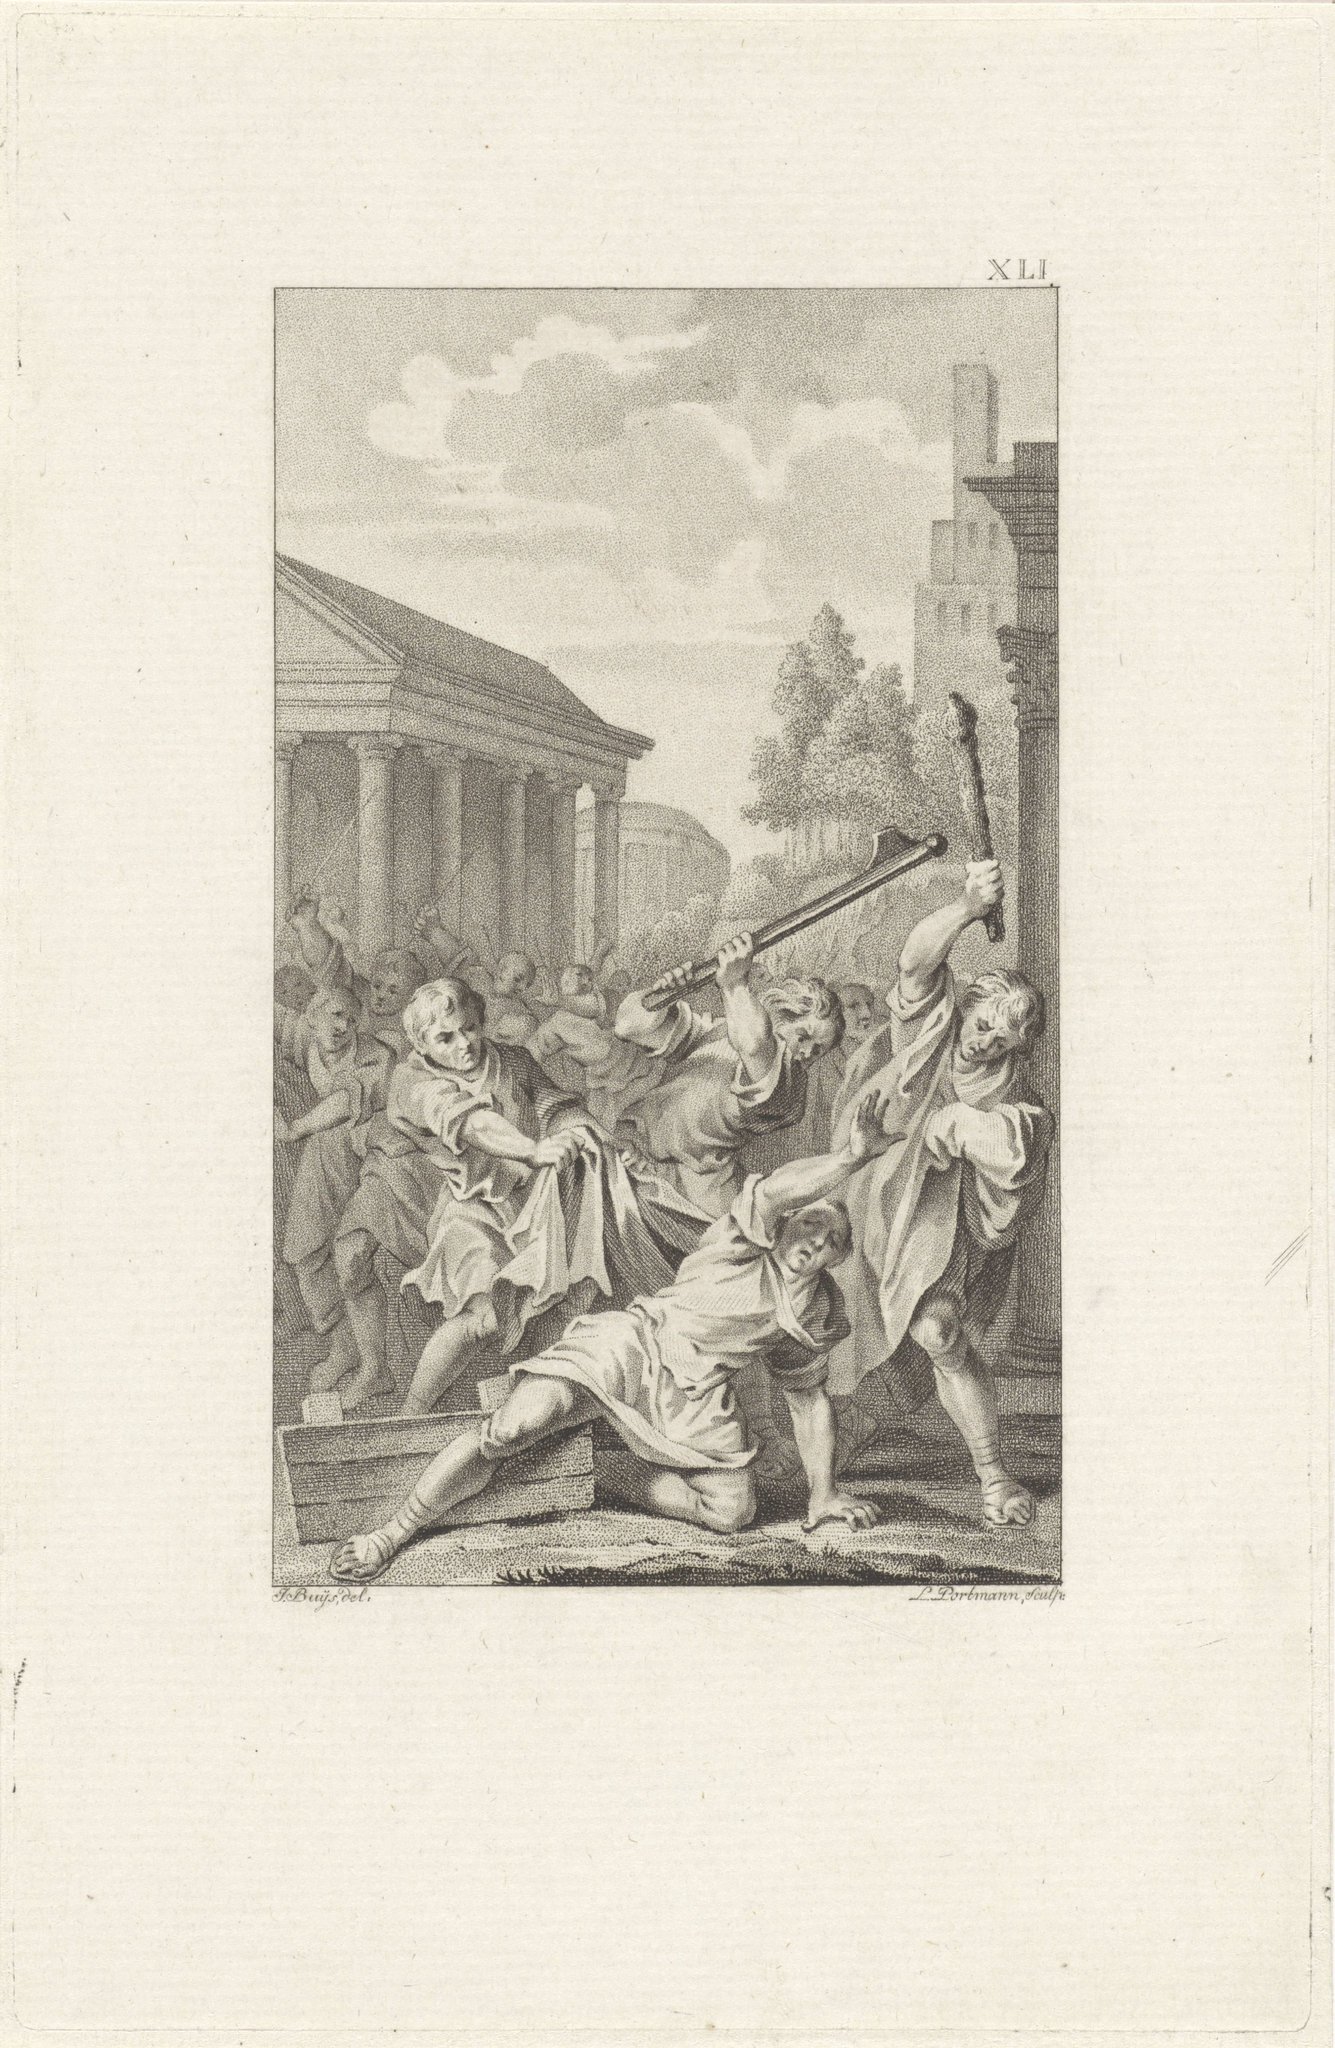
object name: print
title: Moord op Tiberius Gracchus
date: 1797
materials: paper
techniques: etching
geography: amsterdam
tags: male persons from classical history (gracchus tib. s.) - suffering, misfortune of person from classical history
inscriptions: collector's mark: Lugt 2228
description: Tijdens een bijeenkomst op het Capitool wordt Tiberius Sempronius Gracchus III, op bevel van zijn neef Scipio Nasica, door mannen met stokken doodgeslagen.